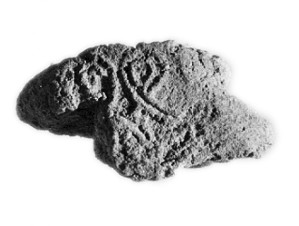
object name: sealing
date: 1981-1640 BCE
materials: mud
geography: egypt